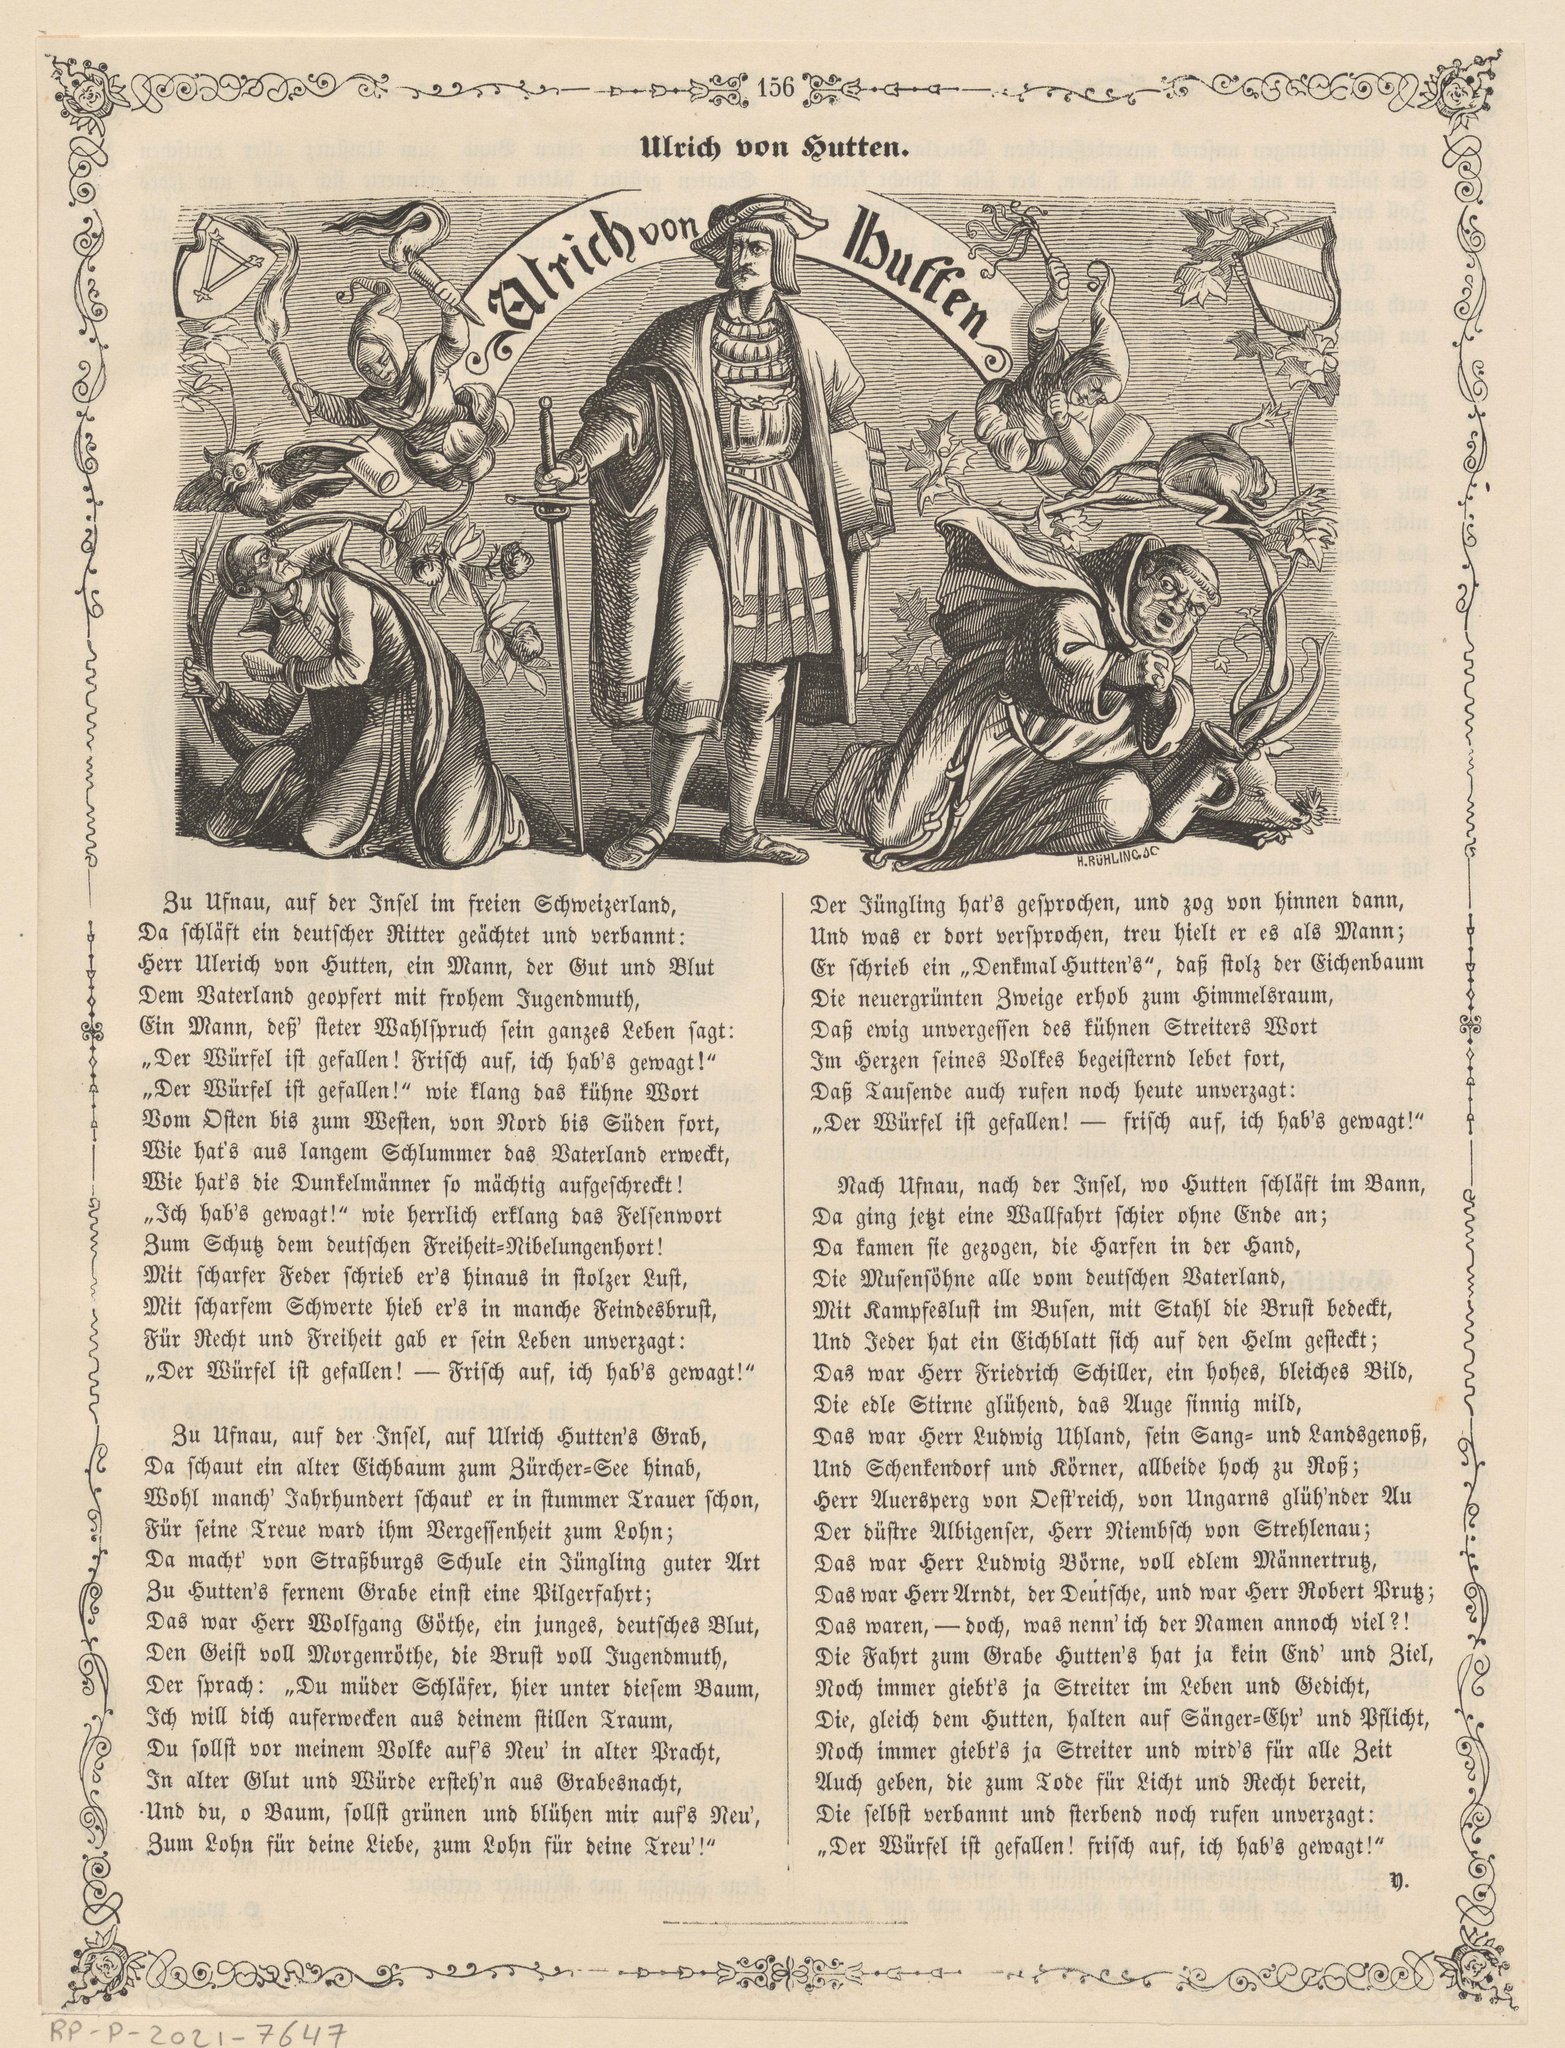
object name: print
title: Portret van Ulrich von Hutten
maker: h. rühling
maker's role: print maker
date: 1848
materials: paper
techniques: letterpress printing, engraving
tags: theologian, historical persons, monk(s), friar(s), armorial bearing, heraldry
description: Met aan weerszijden mannen, waaronder een monnik, die voor hem wegdeinzen.